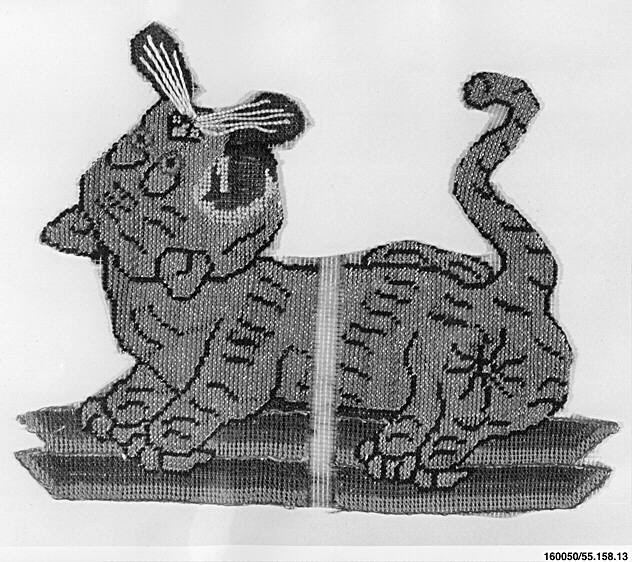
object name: appliqué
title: Applique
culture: chinese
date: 1867-1933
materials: metal thread, silk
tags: animals